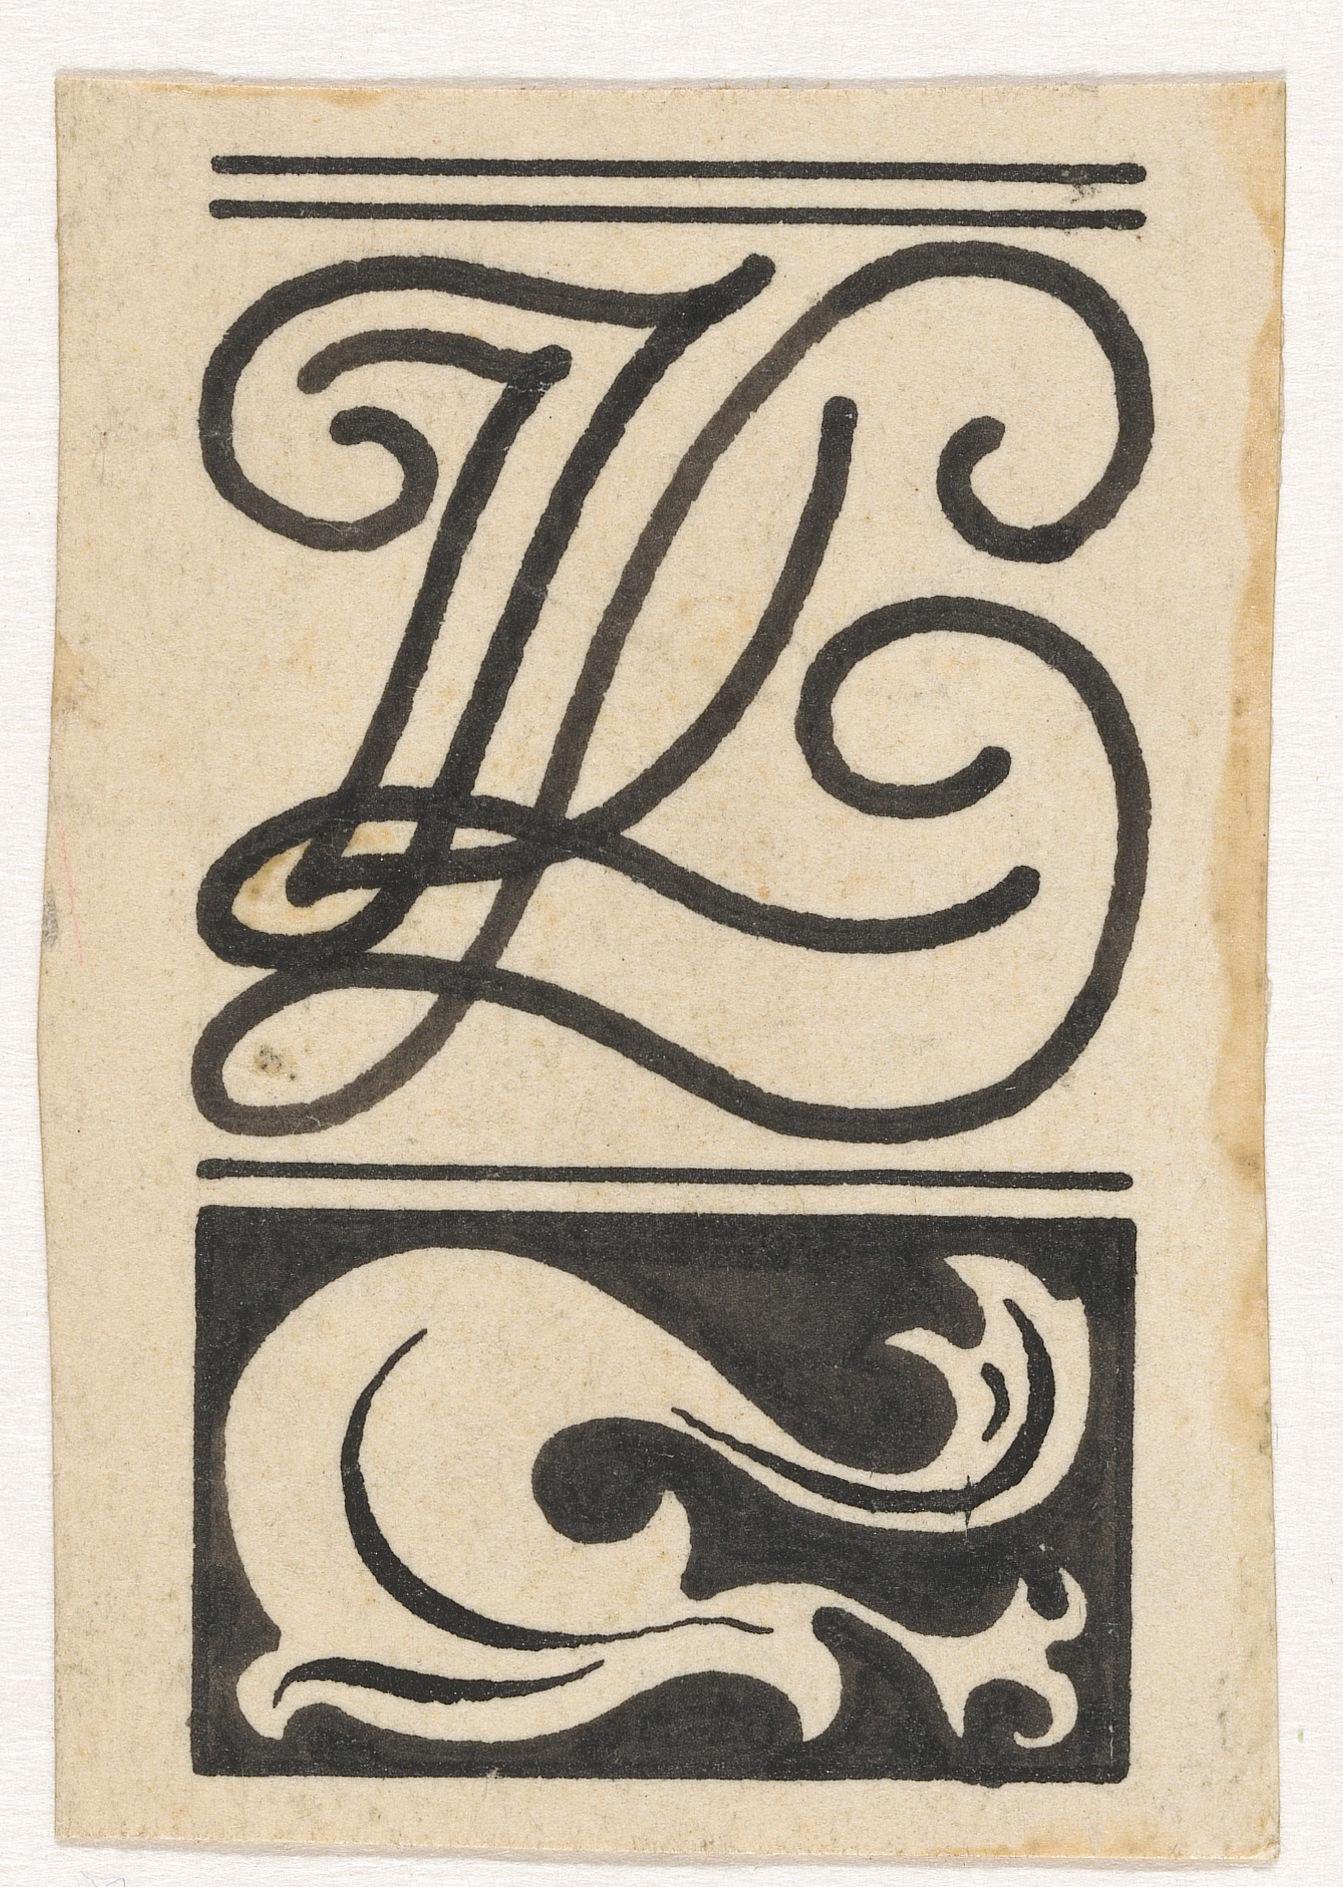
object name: boekillustratie ontwerp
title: Vignet van Uitgeversmaatschappij L.J. Veen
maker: Anonymous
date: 1890-1930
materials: ink, paper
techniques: brush, pen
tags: rocaille ornament, magic mathematical figures; magic numbers, words, monograms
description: Monogram met de letters L, J en V gevat tussen twee parallel lopende horizontale lijnen en een rocaille.